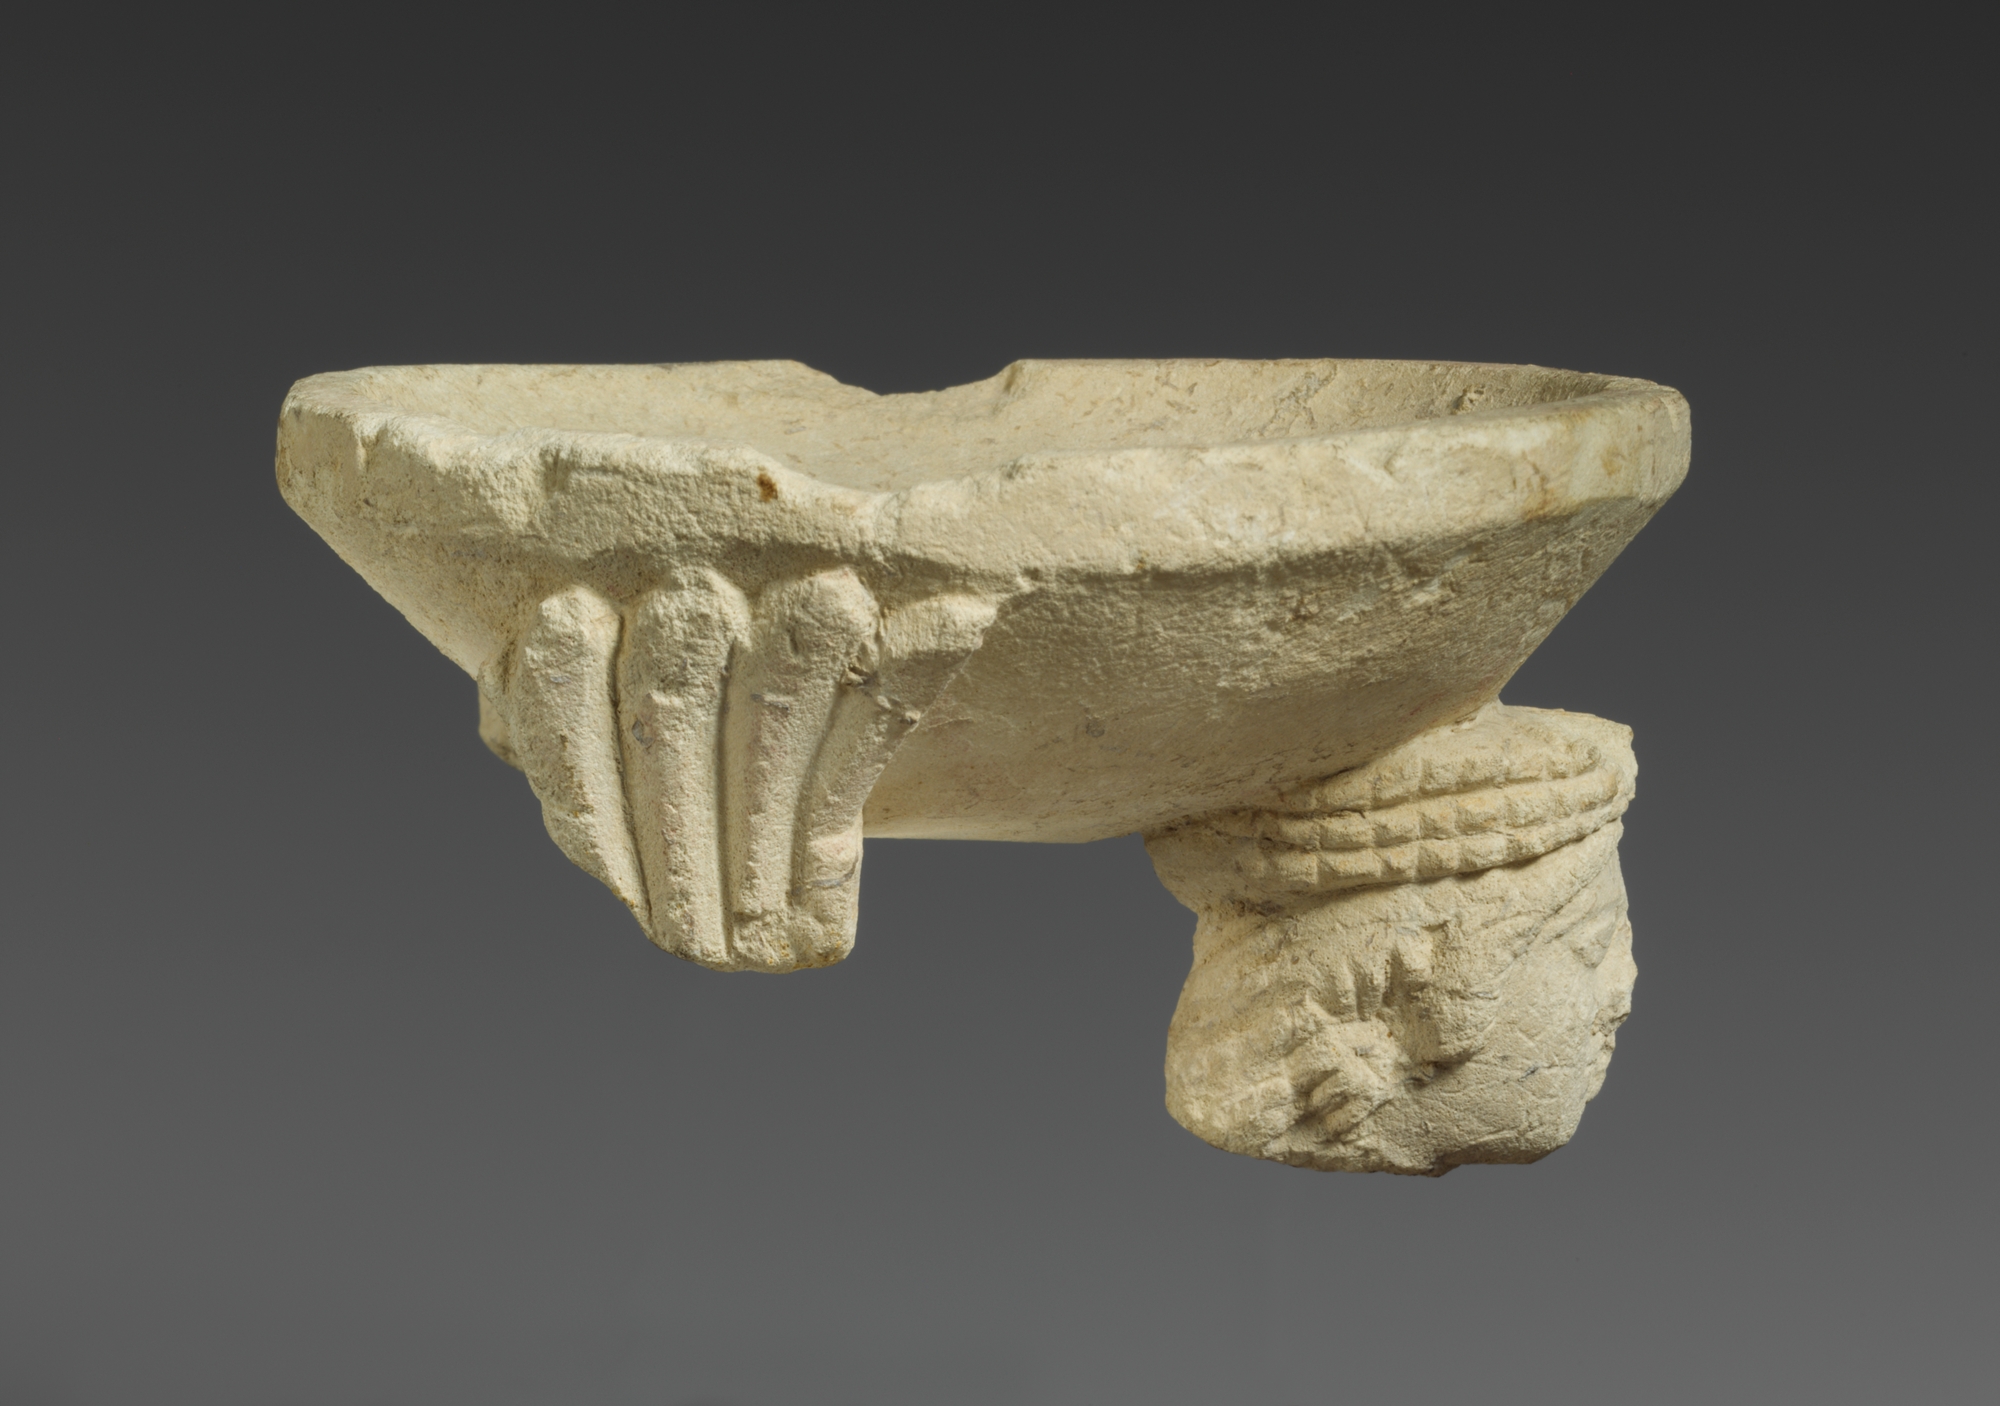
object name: statue of a sphinx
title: Limestone fragment of a sphinx supporting an incense burner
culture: cypriot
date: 467-435 BCE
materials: limestone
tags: sphinx